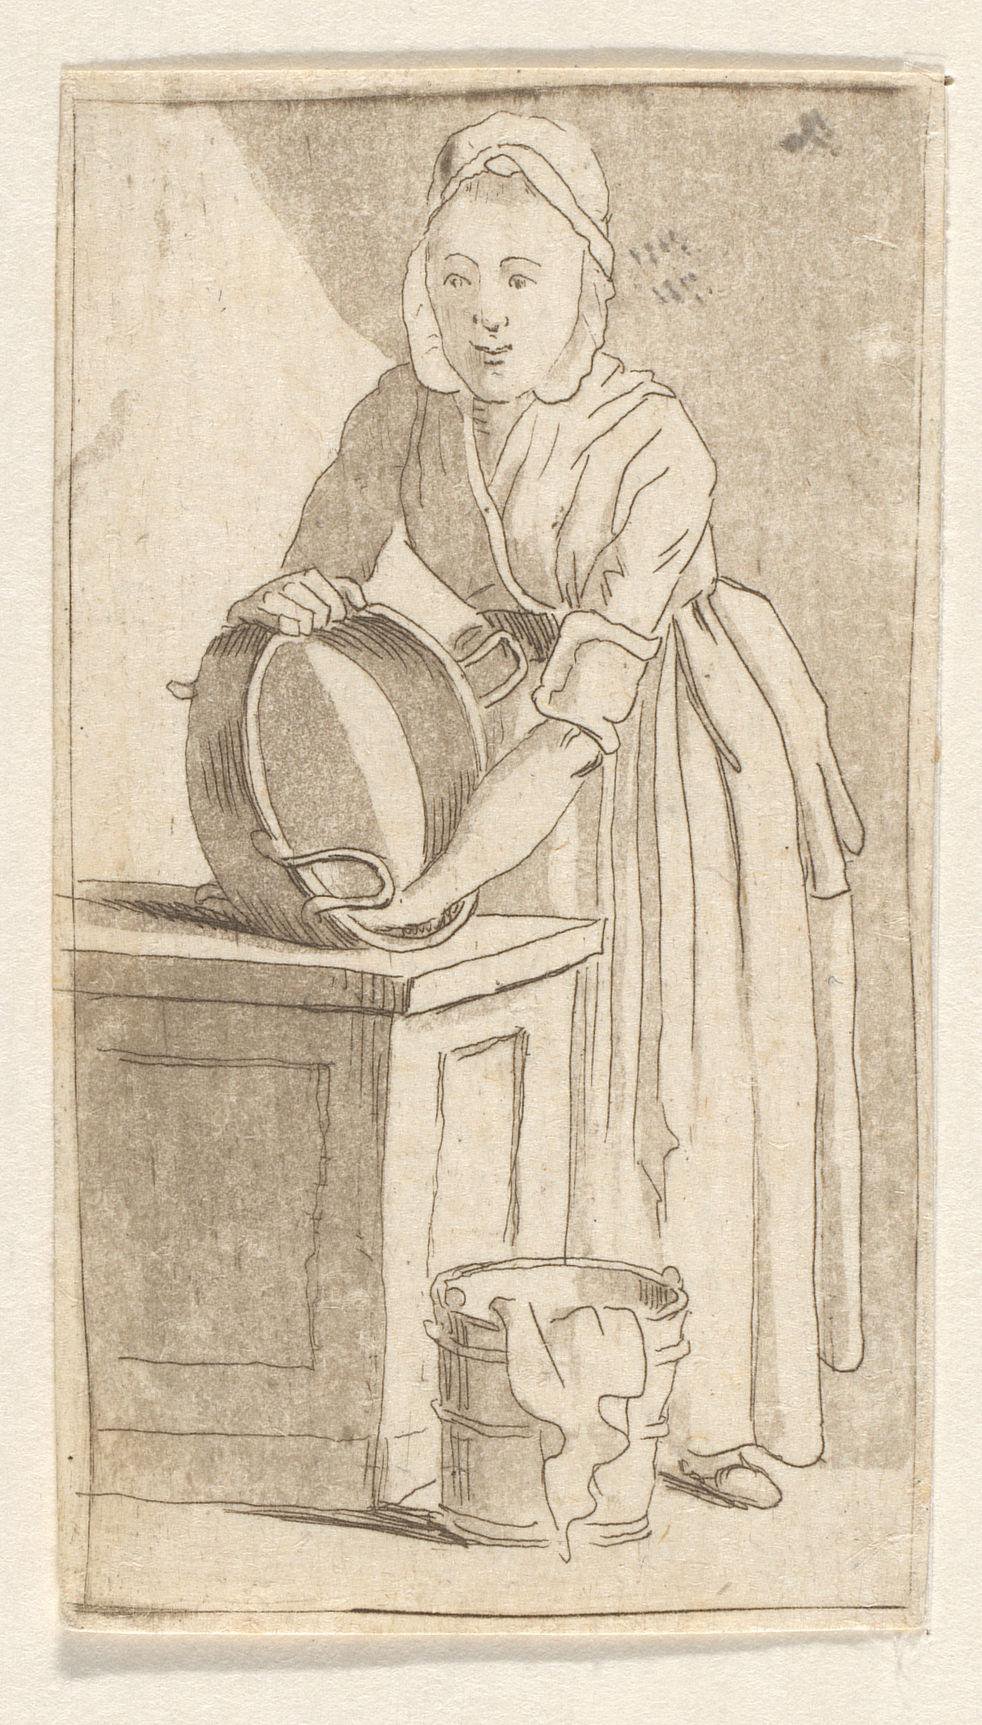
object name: print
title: Dienstmeid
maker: anthonie van den bos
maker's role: draughtsman, print maker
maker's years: 1763-1838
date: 1778-1838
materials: paper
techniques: etching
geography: netherlands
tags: kitchen-maid, kitchen servant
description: Een dienstmeid staat bij het aanrecht en schuurt een pan. Naast het aanrecht staat een emmer met een doek.